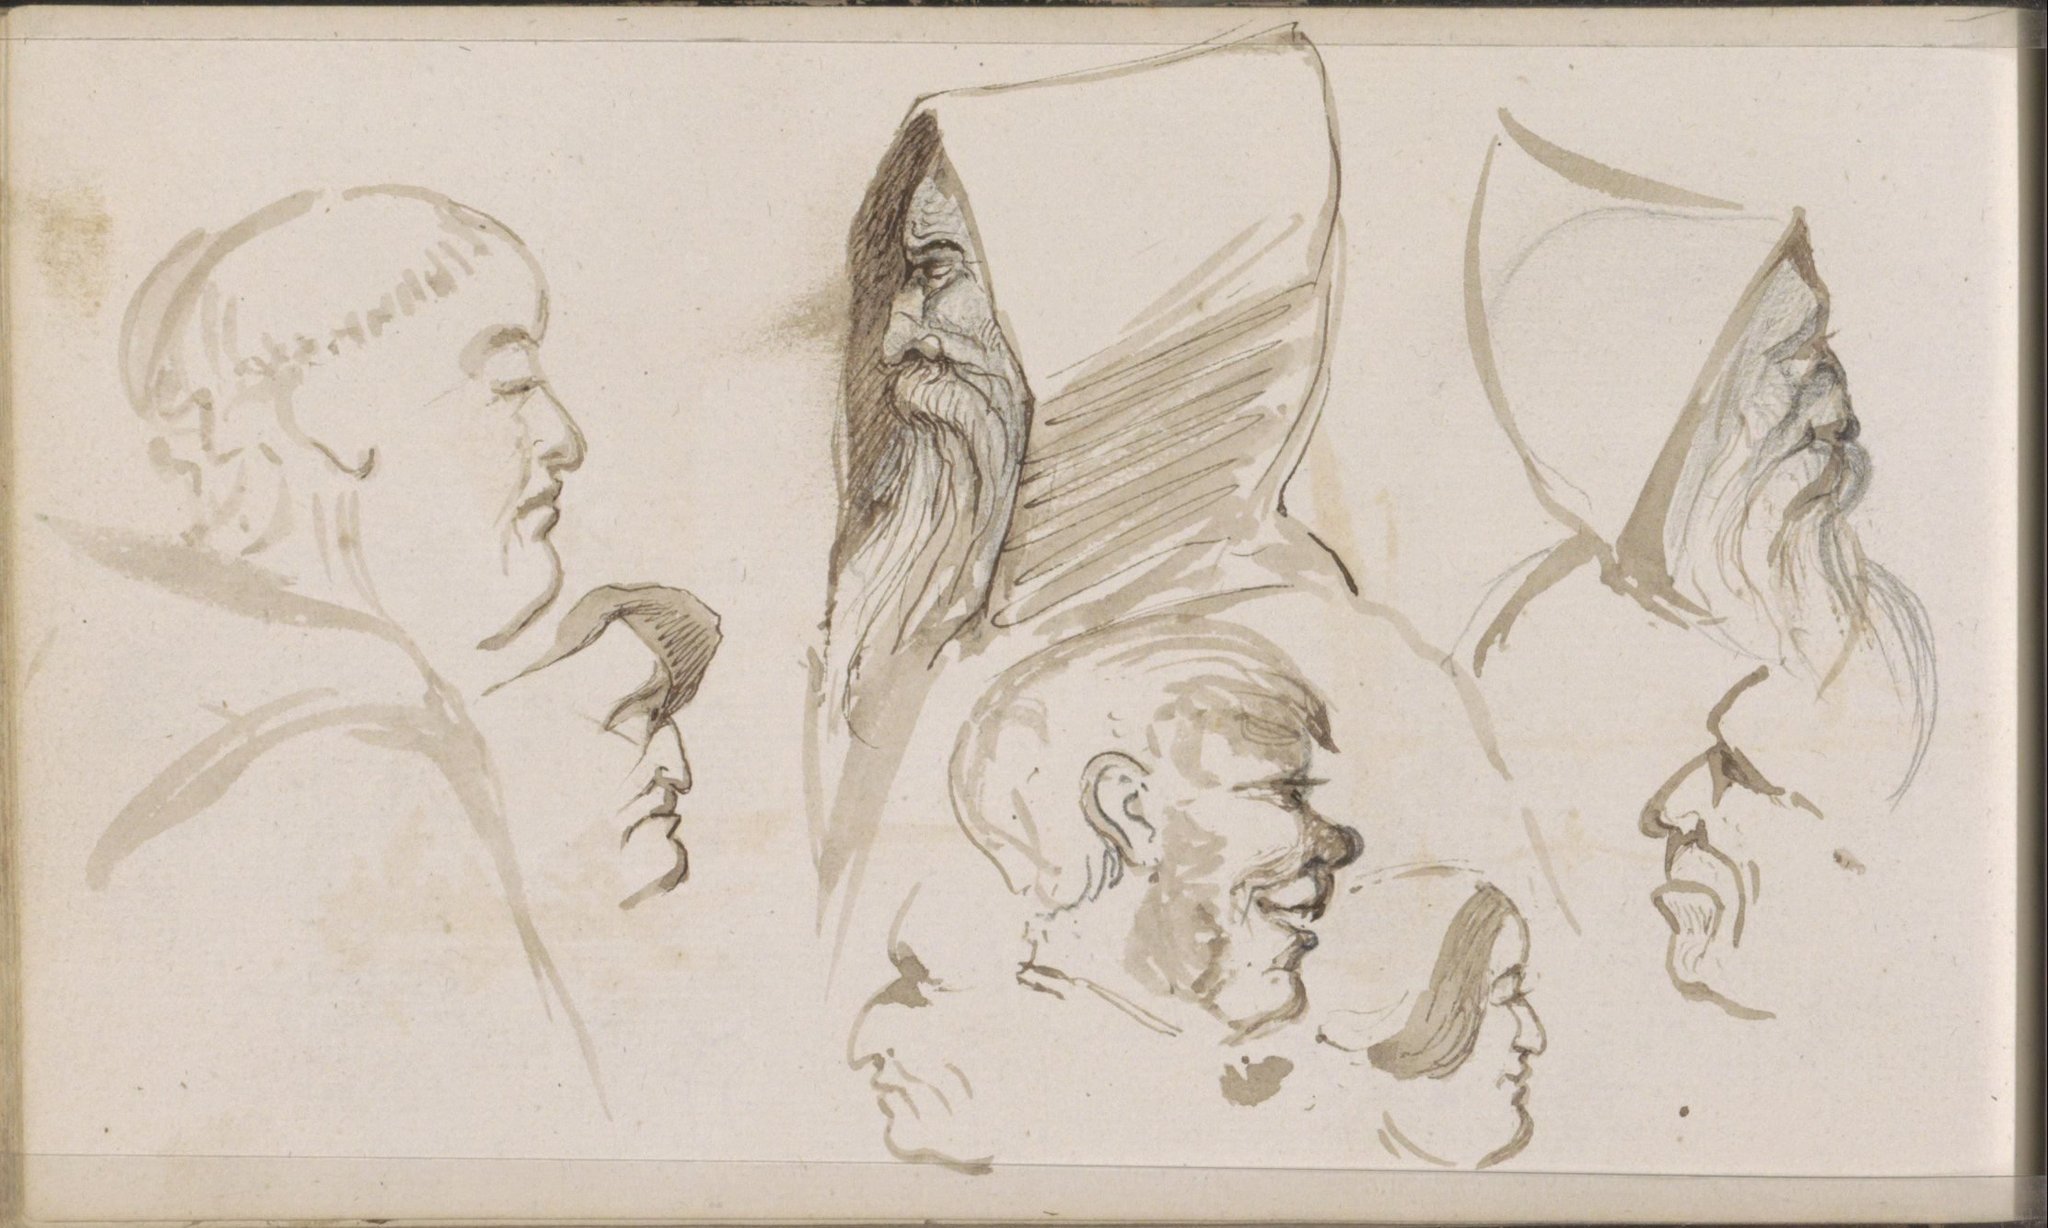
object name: sketchbook leaf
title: Koppen van monniken, mannen en een vrouw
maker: johannes tavenraat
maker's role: draughtsman, painter, print maker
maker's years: 1809-1881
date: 1864-1880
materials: ink, paper, pencil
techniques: brush, pen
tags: head (human), adult woman, adult man, monk(s), friar(s)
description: Blad 65 verso uit een schetsboek met 98 bladen.